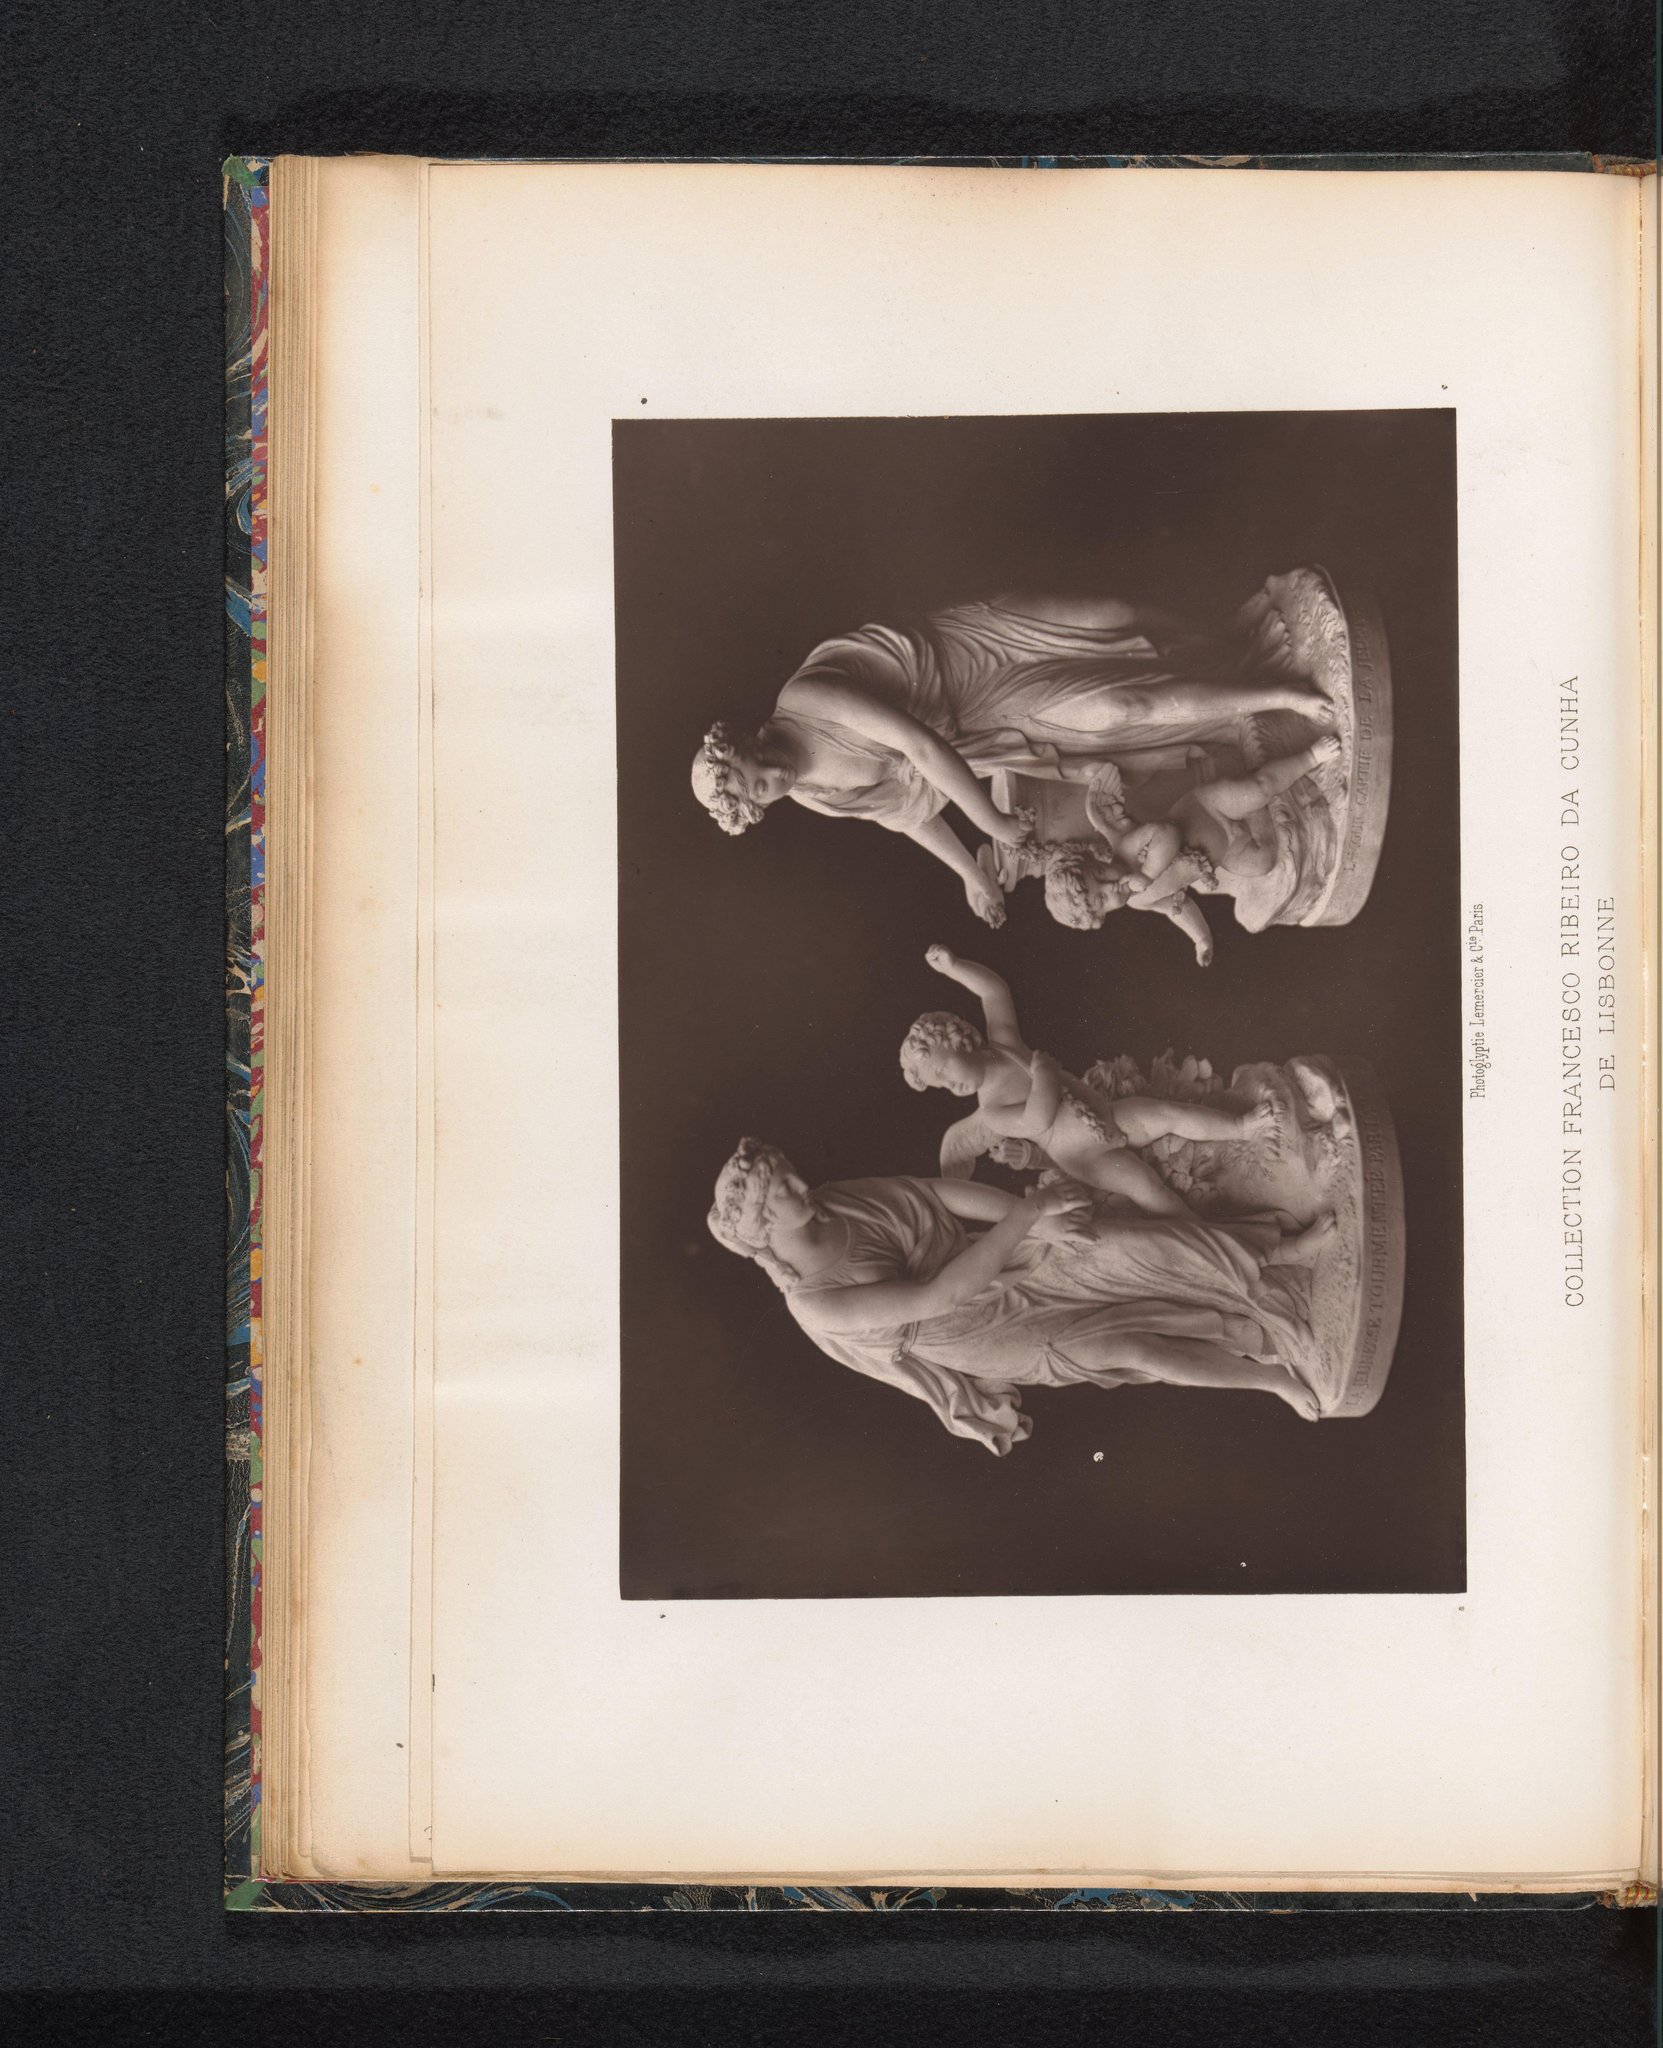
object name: page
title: Twee sculpturen van de liefde die de jeugd vangt en kwelt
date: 1879-1884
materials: paper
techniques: woodburytype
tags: cupid struggling with or tormenting other persons, abstract concepts, (fabulous) animals, etc.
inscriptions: inscription: ‘Collection Francesco Riberio da Cunha de Lisbonne’